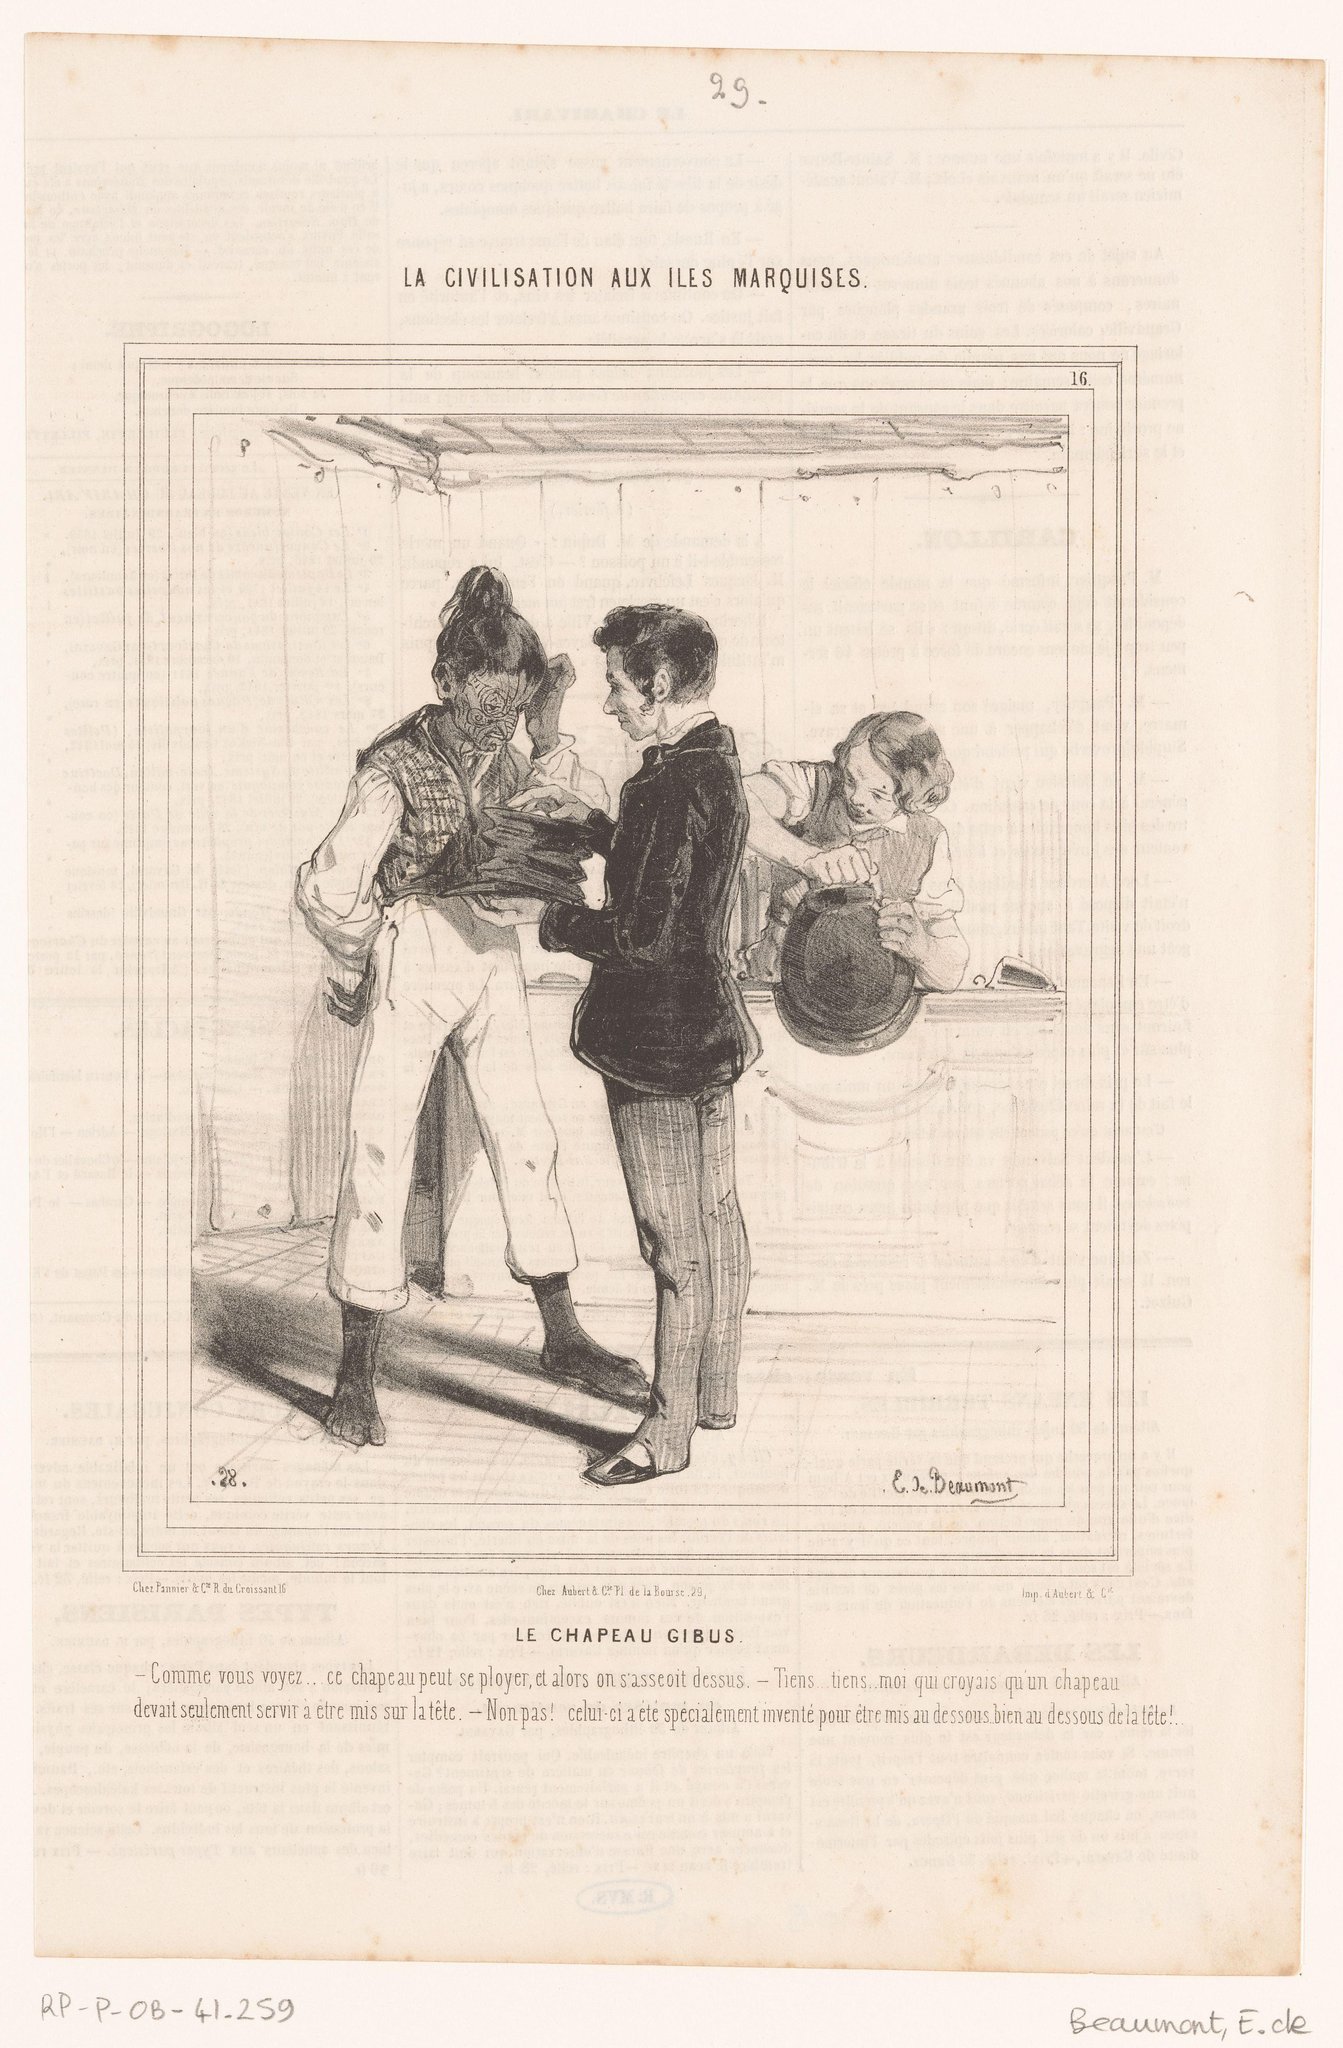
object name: cartoon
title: La civilisation aux îles Marquises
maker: edouard de beaumont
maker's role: draughtsman, painter, print maker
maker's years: 1812-1888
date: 1843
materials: paper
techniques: letterpress printing, lithograph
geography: paris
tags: colonial system, australian and oceanian races (+ caricatured), head-gear: hat, marquesas archipelago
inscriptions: collector's mark: Lugt 2228a, number: ‘29’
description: Een Fransman houdt een oorspronkelijke inwoner van de Markiezenarchipel voor de gek, door hem wijs te maken dat de geplooide 'gibus' (hoge hoed) ontworpen is om er op te zitten.